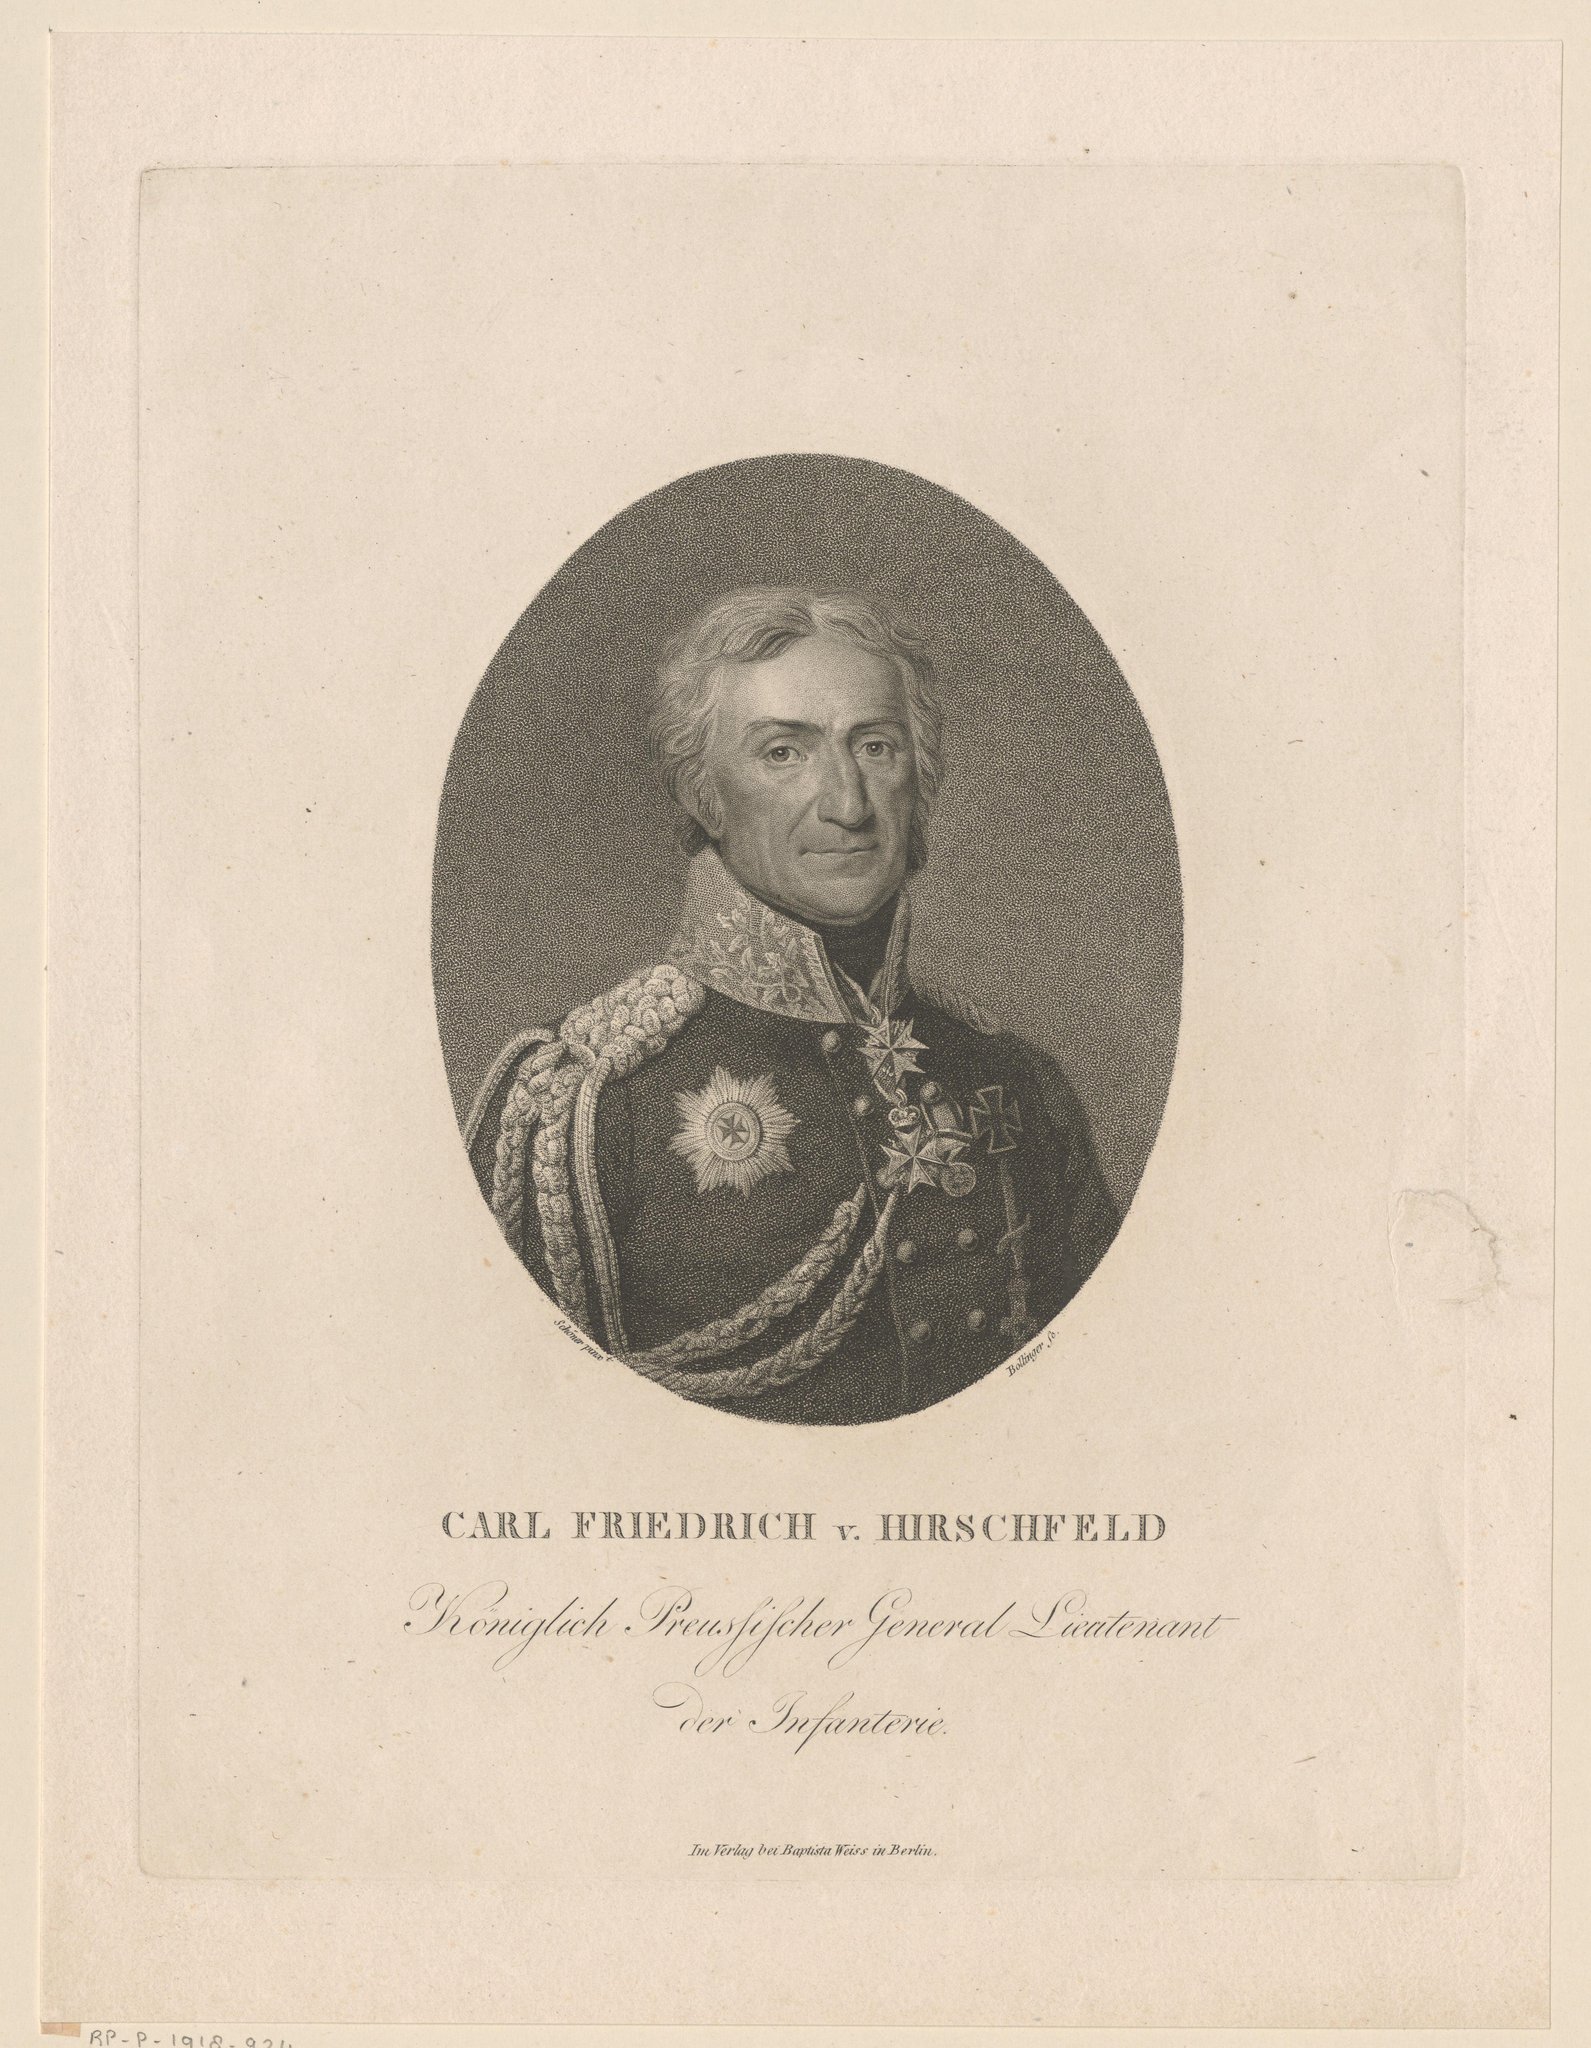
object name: print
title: Portret van Karl Friedrich von Hirschfeld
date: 1814-1825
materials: paper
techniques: engraving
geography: berlin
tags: commander-in-chief, general, marshal, historical persons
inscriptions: collector's mark: Lugt 2233